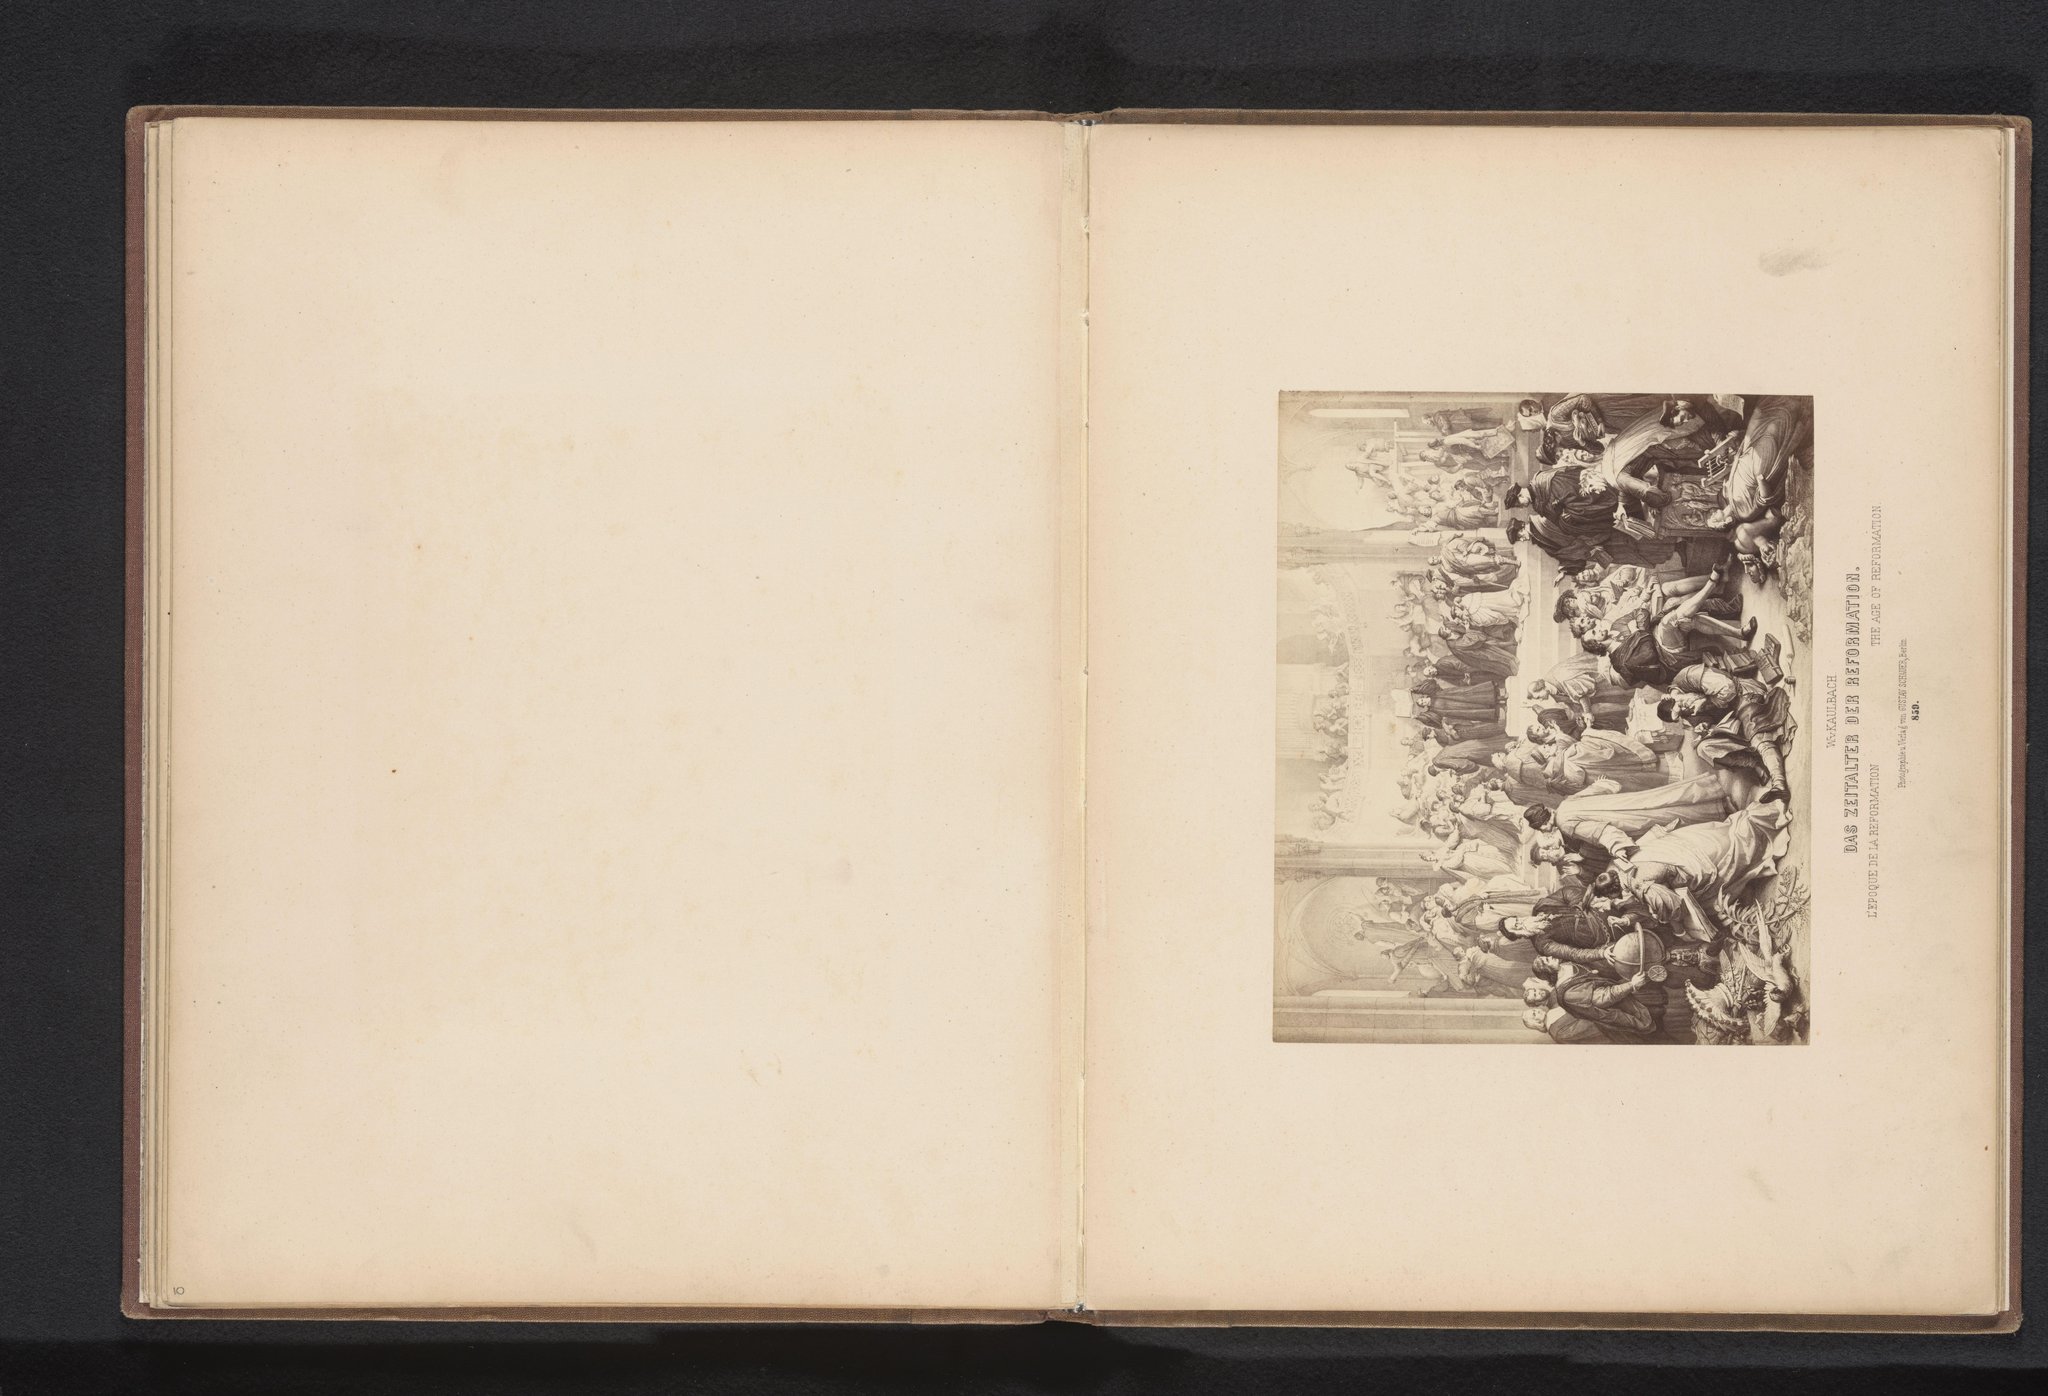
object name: photograph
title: Das zeitalter der Reformation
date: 1860-1870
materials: photographic support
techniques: albumen print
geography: berlin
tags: reformation (roman catholic church vs. protestantism), wall-covering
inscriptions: number: ‘859.’